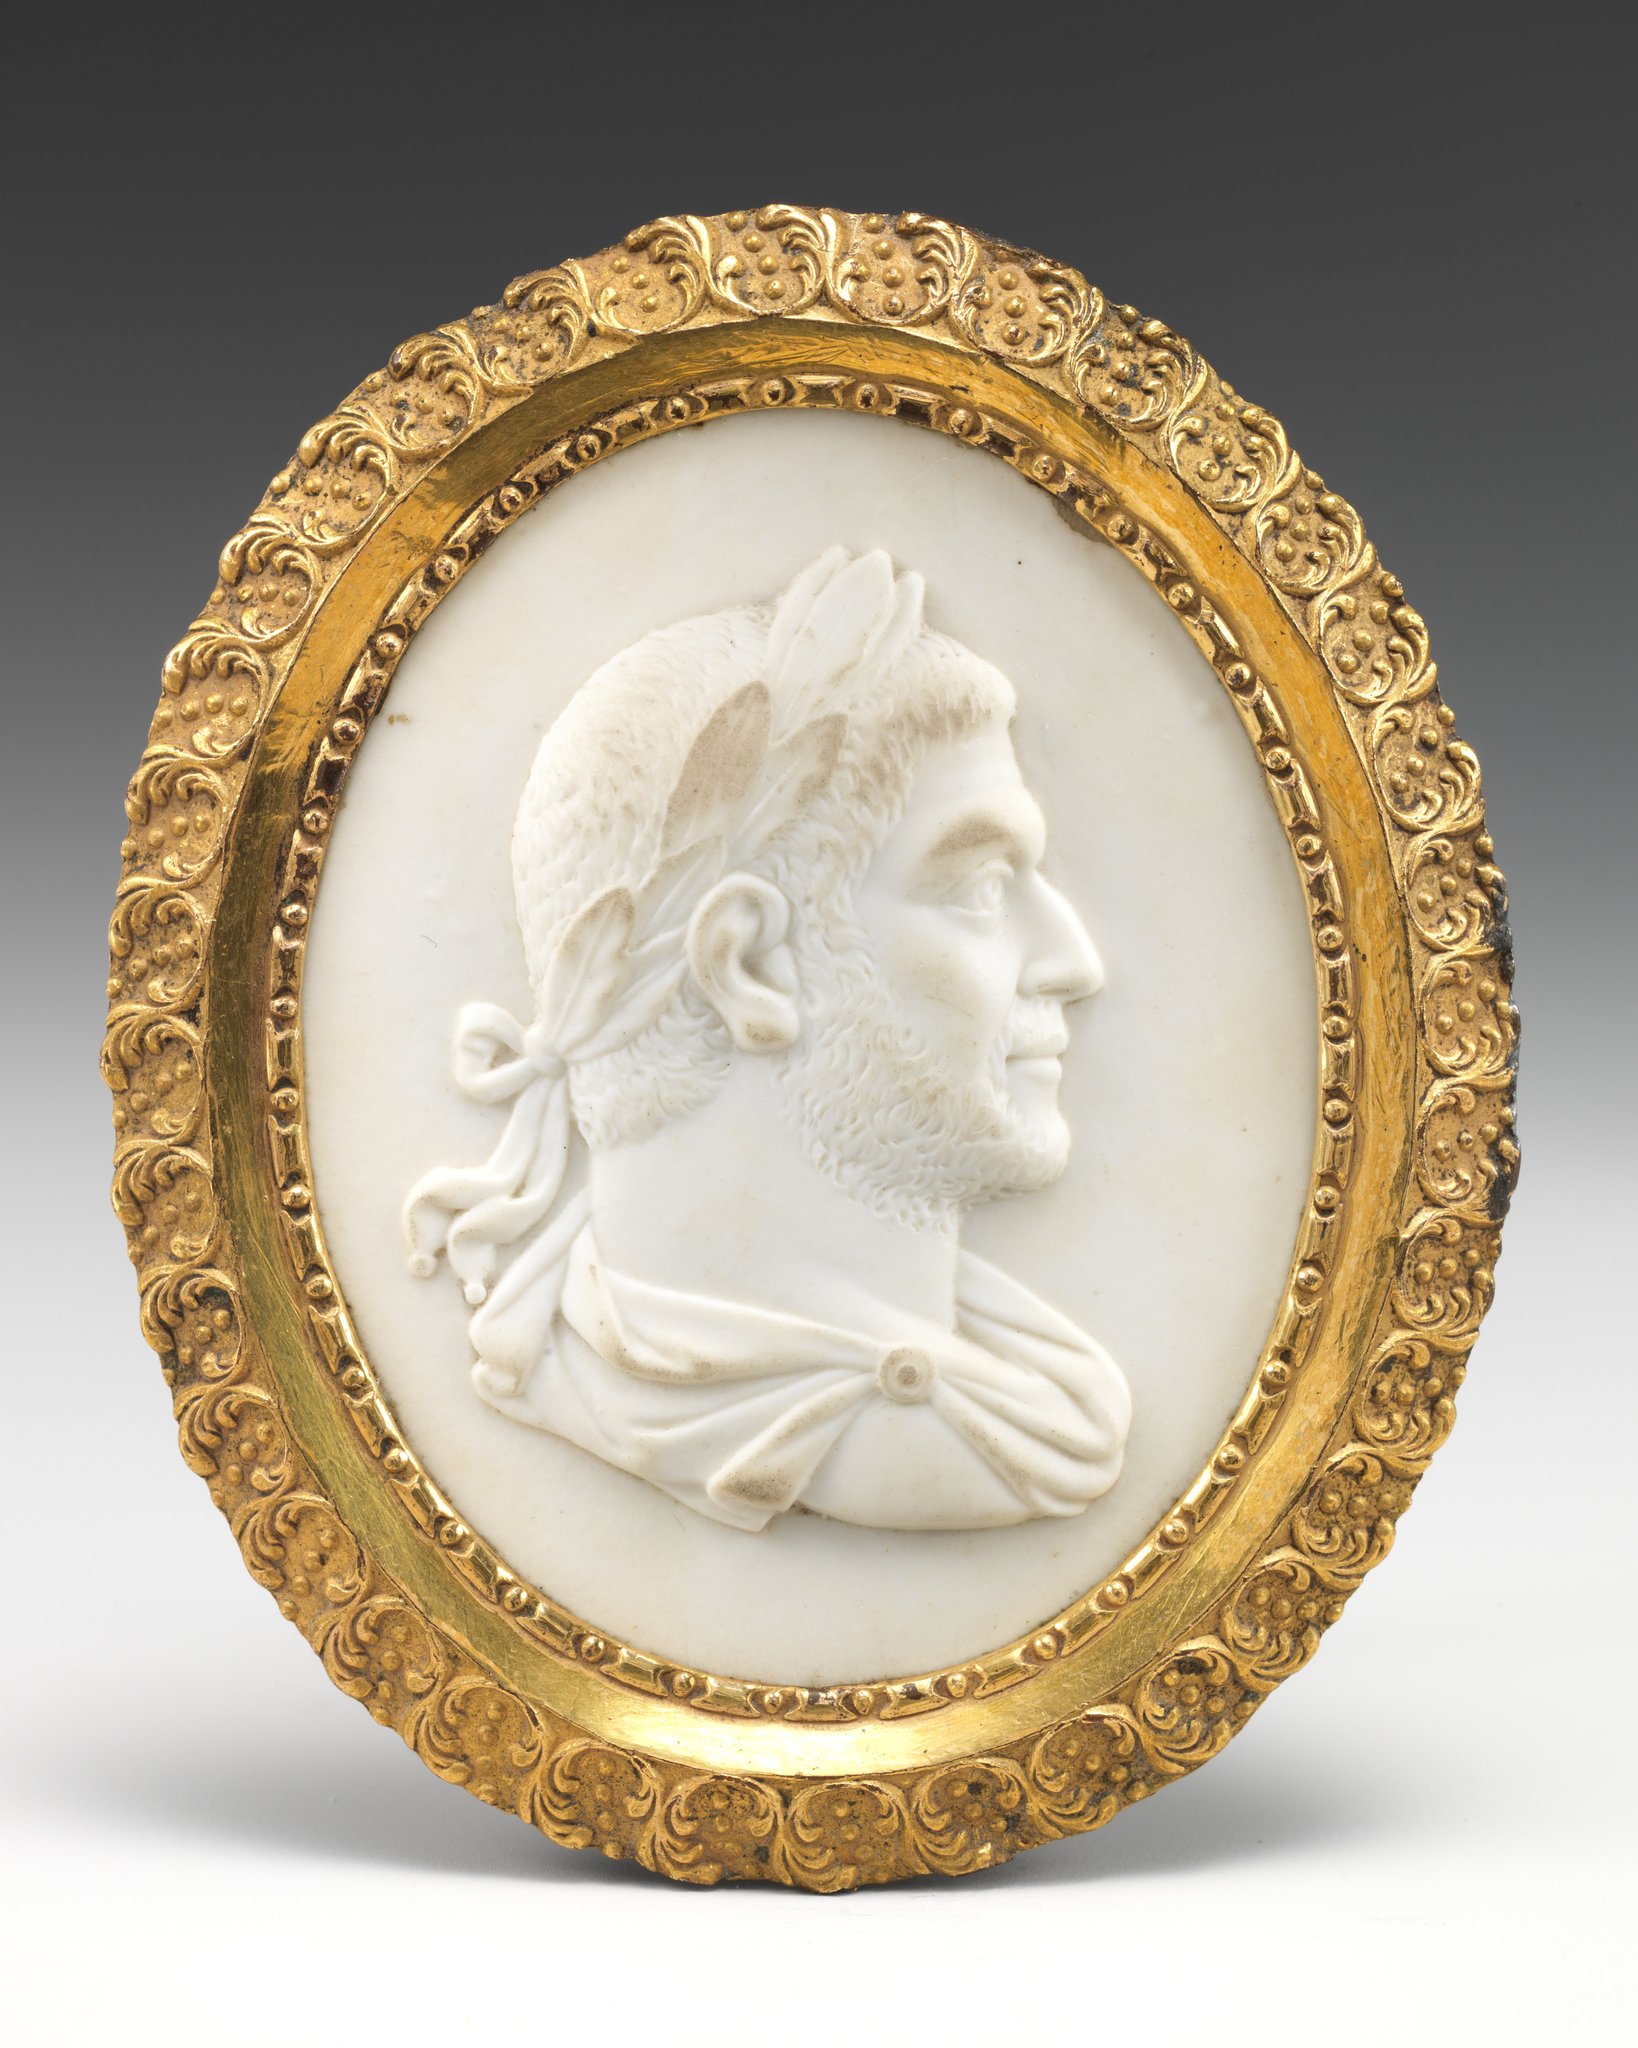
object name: cameo medallion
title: Emperor Marcus Julius Philippus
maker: wedgwood and bentley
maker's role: manufacturer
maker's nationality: british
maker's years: 1769-1780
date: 1701-1800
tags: kings,men,profiles